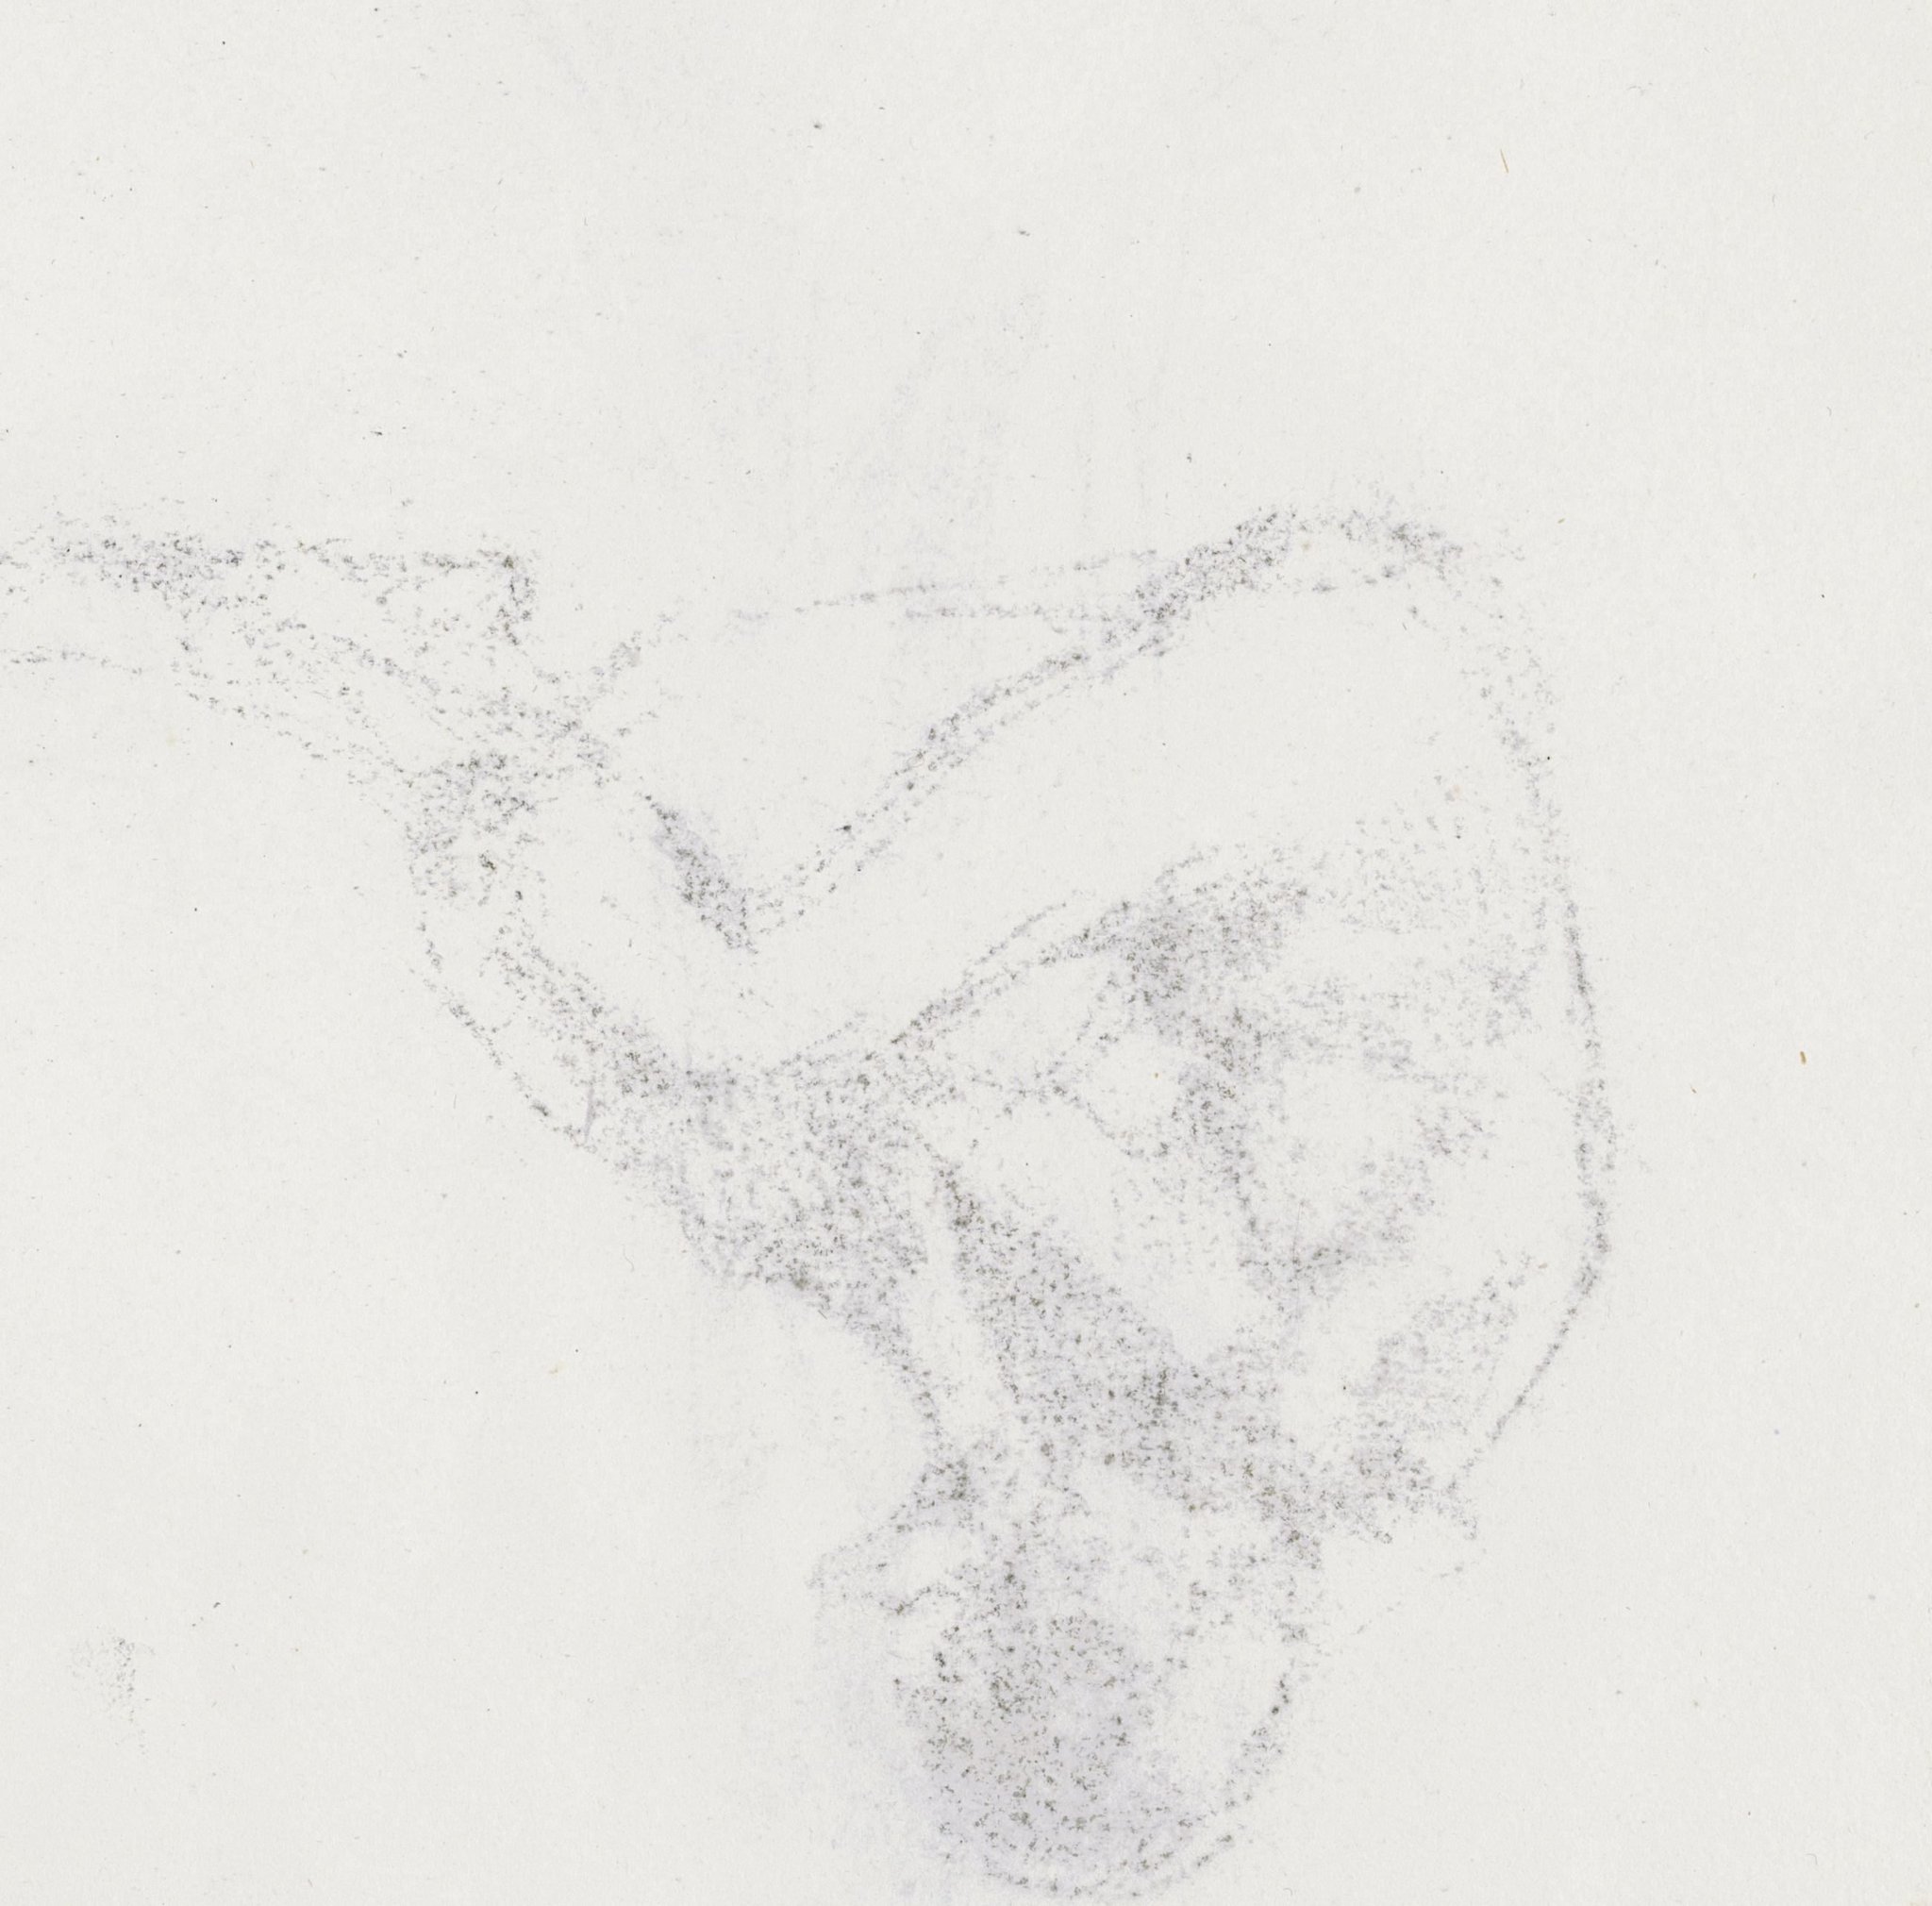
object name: sketchbook leaf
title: Abklatsch van de krijttekening op blad 20 verso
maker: isaac israels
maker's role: draughtsman, painter, print maker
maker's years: 1865-1934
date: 1875-1934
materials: paper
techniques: printmaking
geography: the hague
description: Blad 21 recto uit schetsboek IX met 28 bladen.